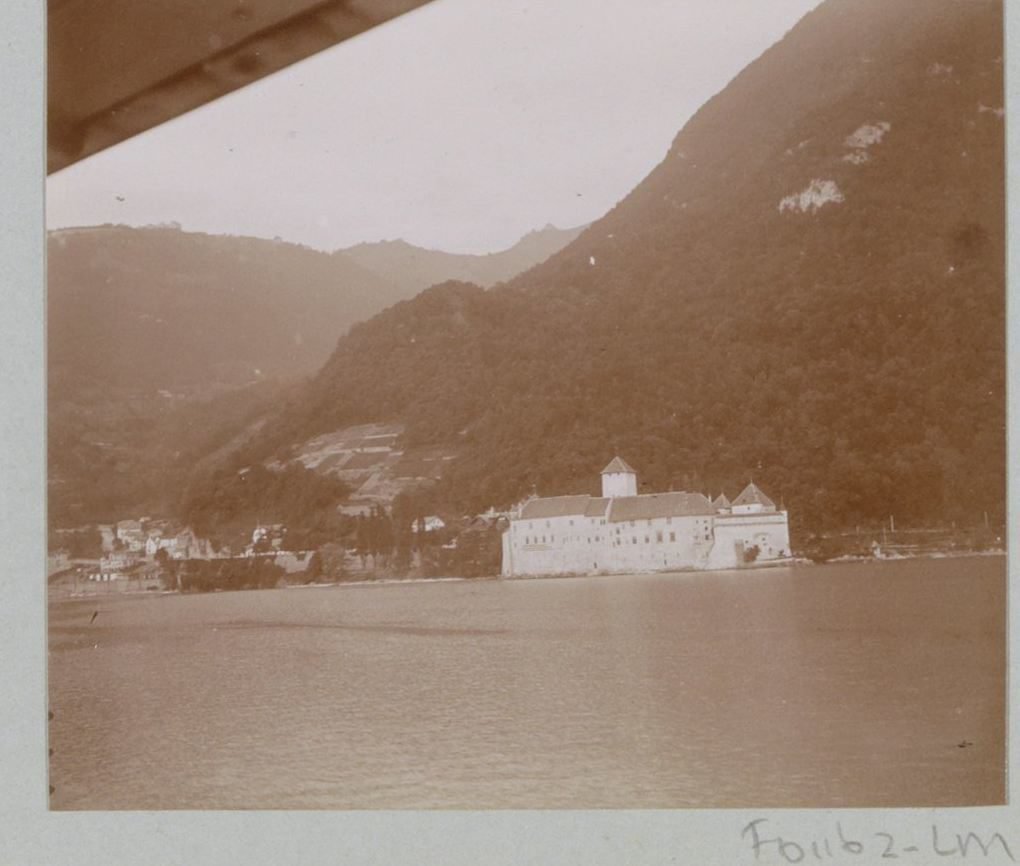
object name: photograph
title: Gezicht op het Kasteel van Chillon aan het Meer van Genève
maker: Anonymous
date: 1905-1910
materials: paper, photographic support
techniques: gelatin silver print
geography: lake geneva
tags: castle, lake, mountain-range, snow peaks, switzerland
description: Onderdeel van Fotoalbum van een Franse amateurfotograaf met bezienswaardigheden in Frankrijk, Zwitserland en Italië.